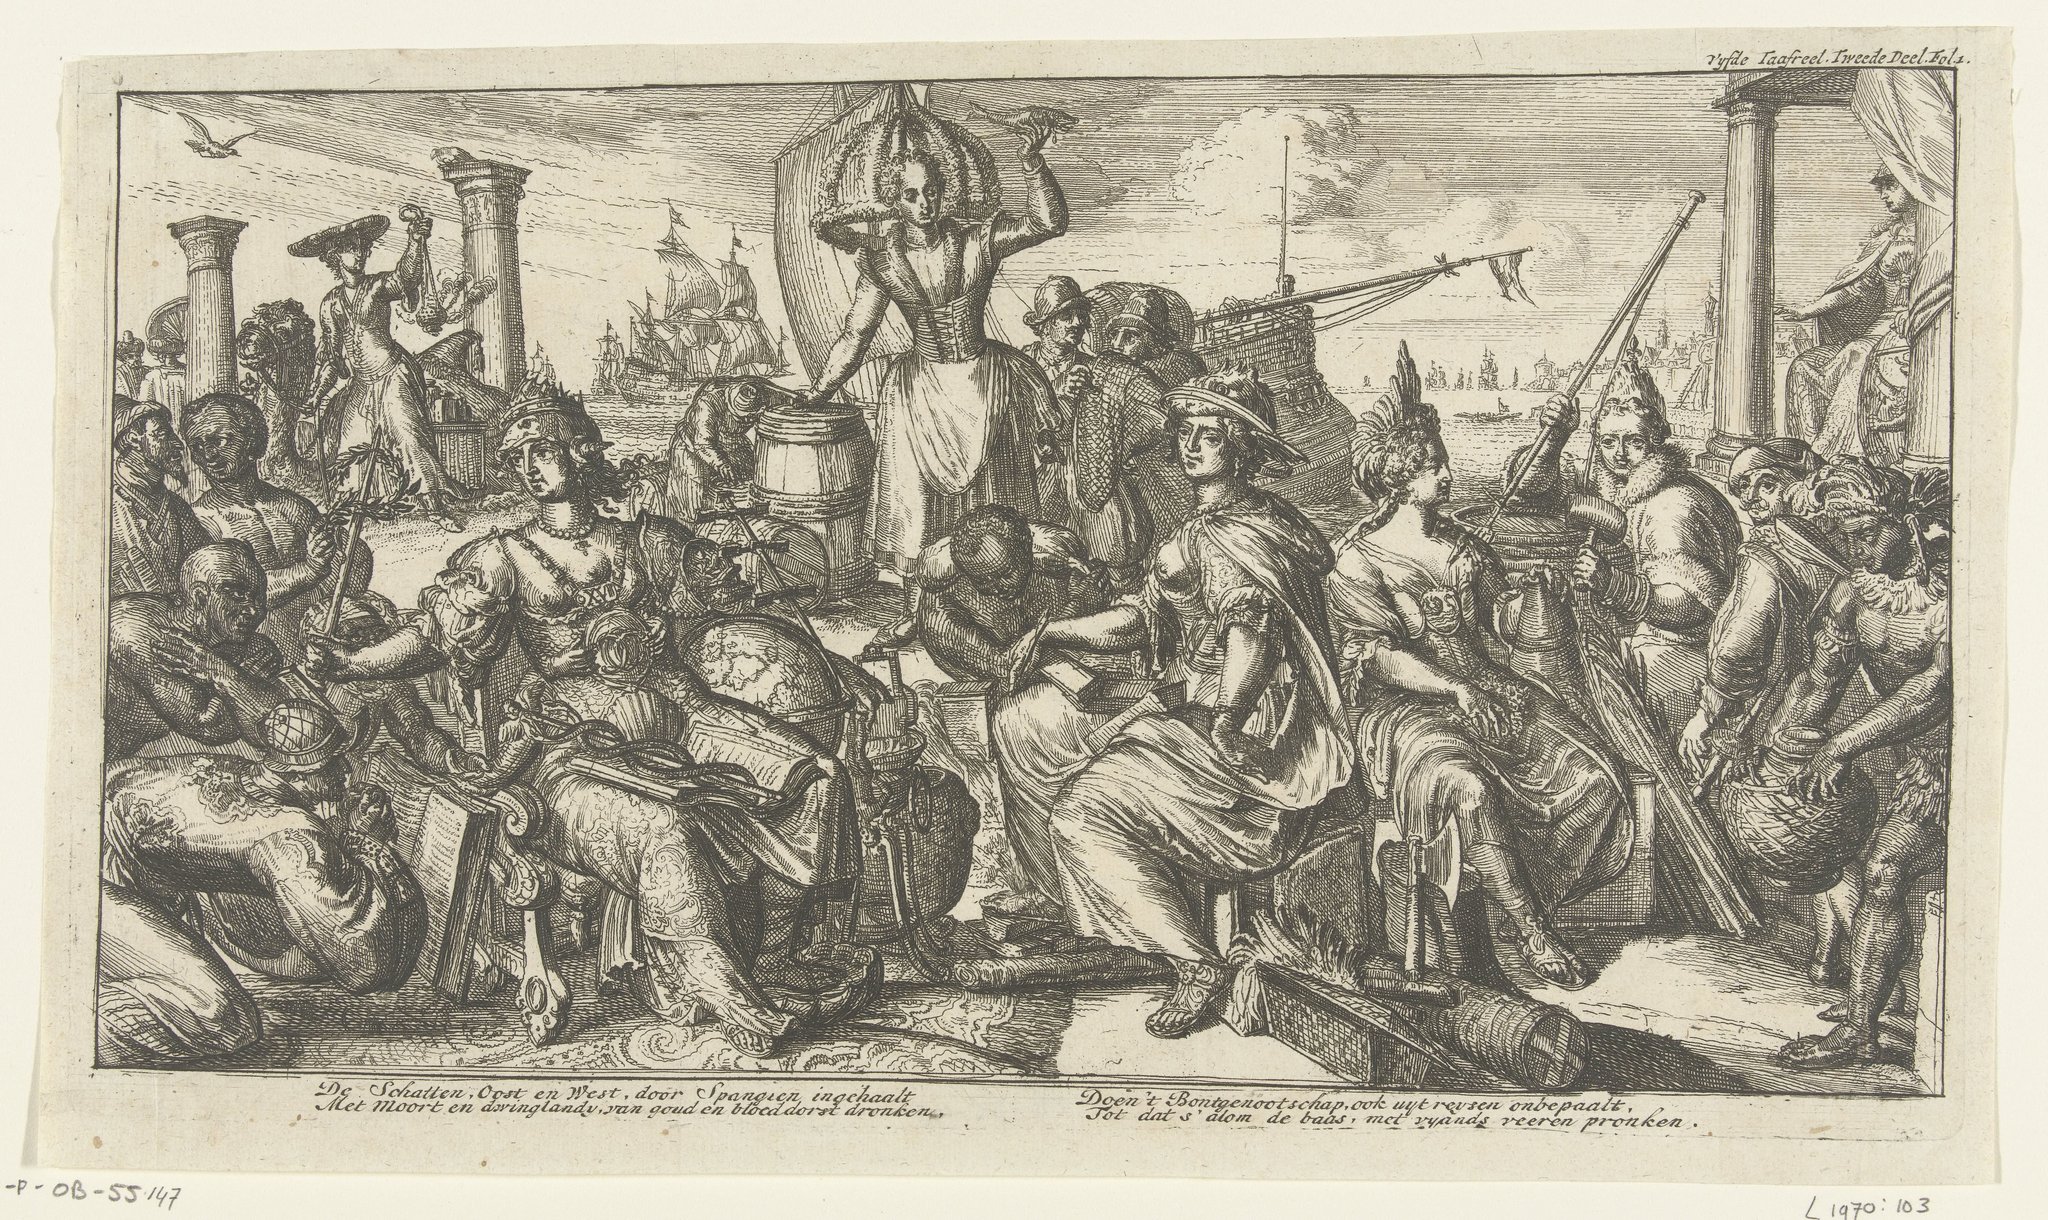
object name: print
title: Allegorie op de Oost- en West-Indische Maatschappij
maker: romeyn de hooghe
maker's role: draughtsman, goldsmith, painter, print maker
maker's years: 1645-1708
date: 1705-1707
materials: paper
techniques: etching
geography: netherlands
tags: justice, 'justitia'; 'giustitia divina' (ripa) ~ one of the four cardinal virtues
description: Illustratie voor: R. de Hooghe, Spiegel van Staat, Vervattende de Macht der Generaliteyts, J. ten Hoorn, Amsterdam 1707, dl. II, vijfde tafereel, p. 1.